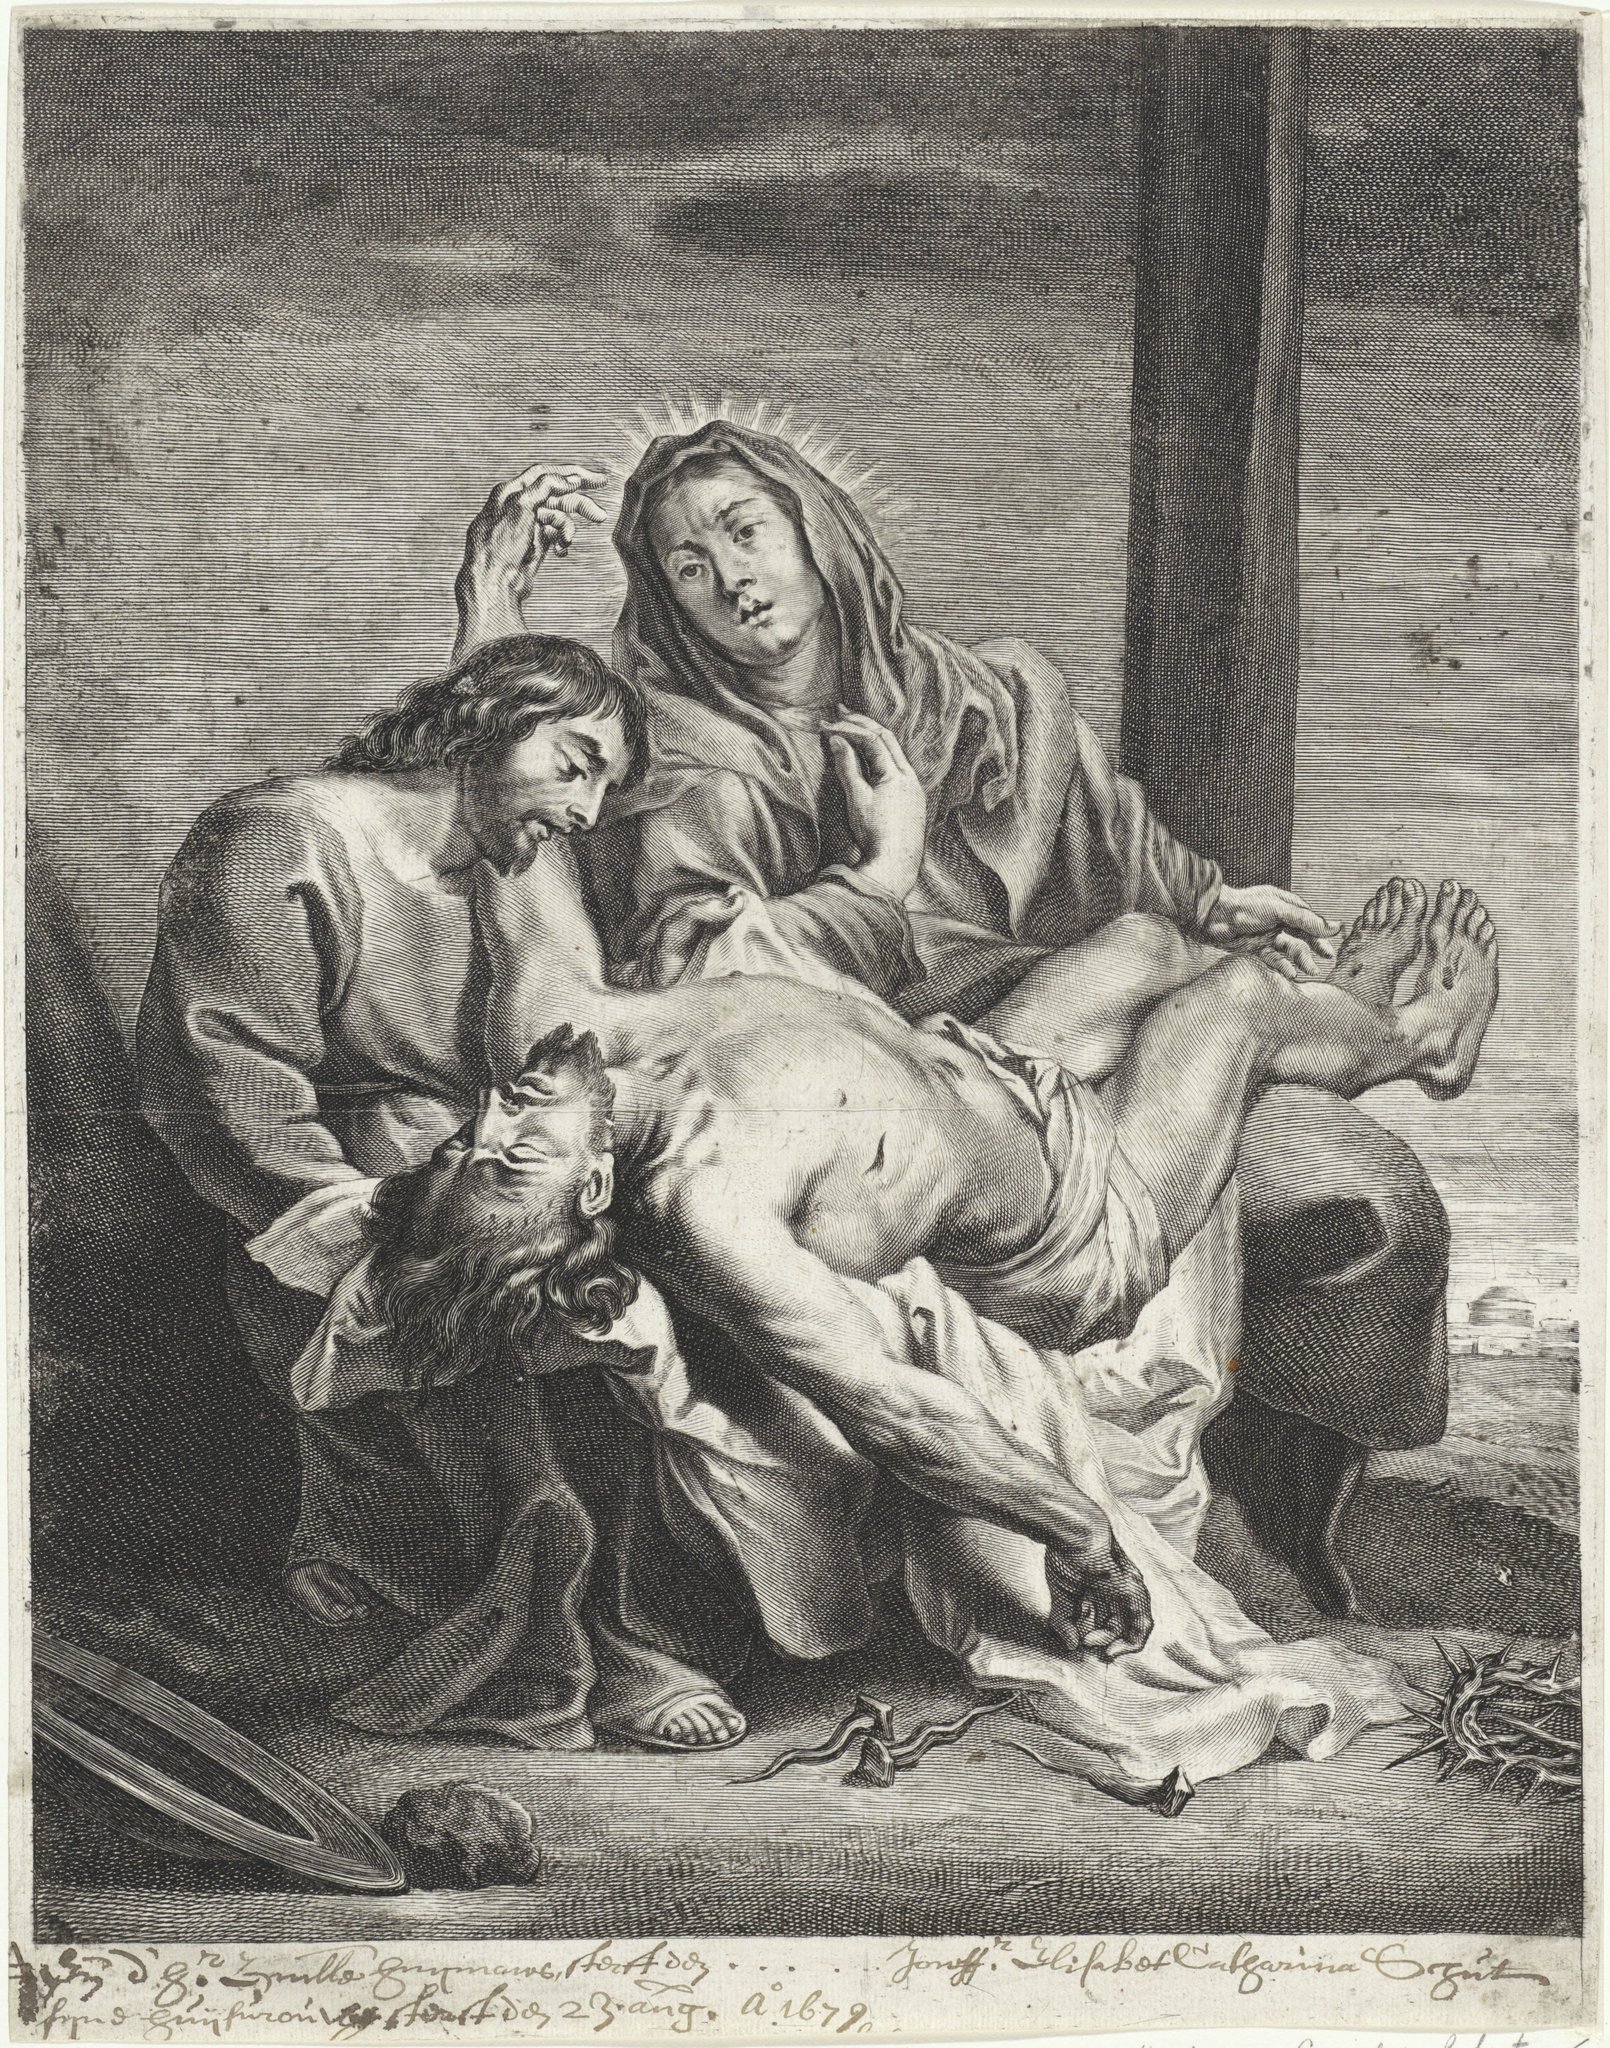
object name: print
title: Bewening van Christus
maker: Anonymous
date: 1636-1679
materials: paper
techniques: engraving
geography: antwerp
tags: christ's body supported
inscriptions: collector's mark: Lugt 240, date: ‘[...] 23 aug Ao. 1679’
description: Het lichaam van Christus ligt bij de rouwende Maria op schoot. Zijn hoofd wordt door Johannes ondersteund. Achter hen het kruis. Voor hen liggen de passiewerktuigen.